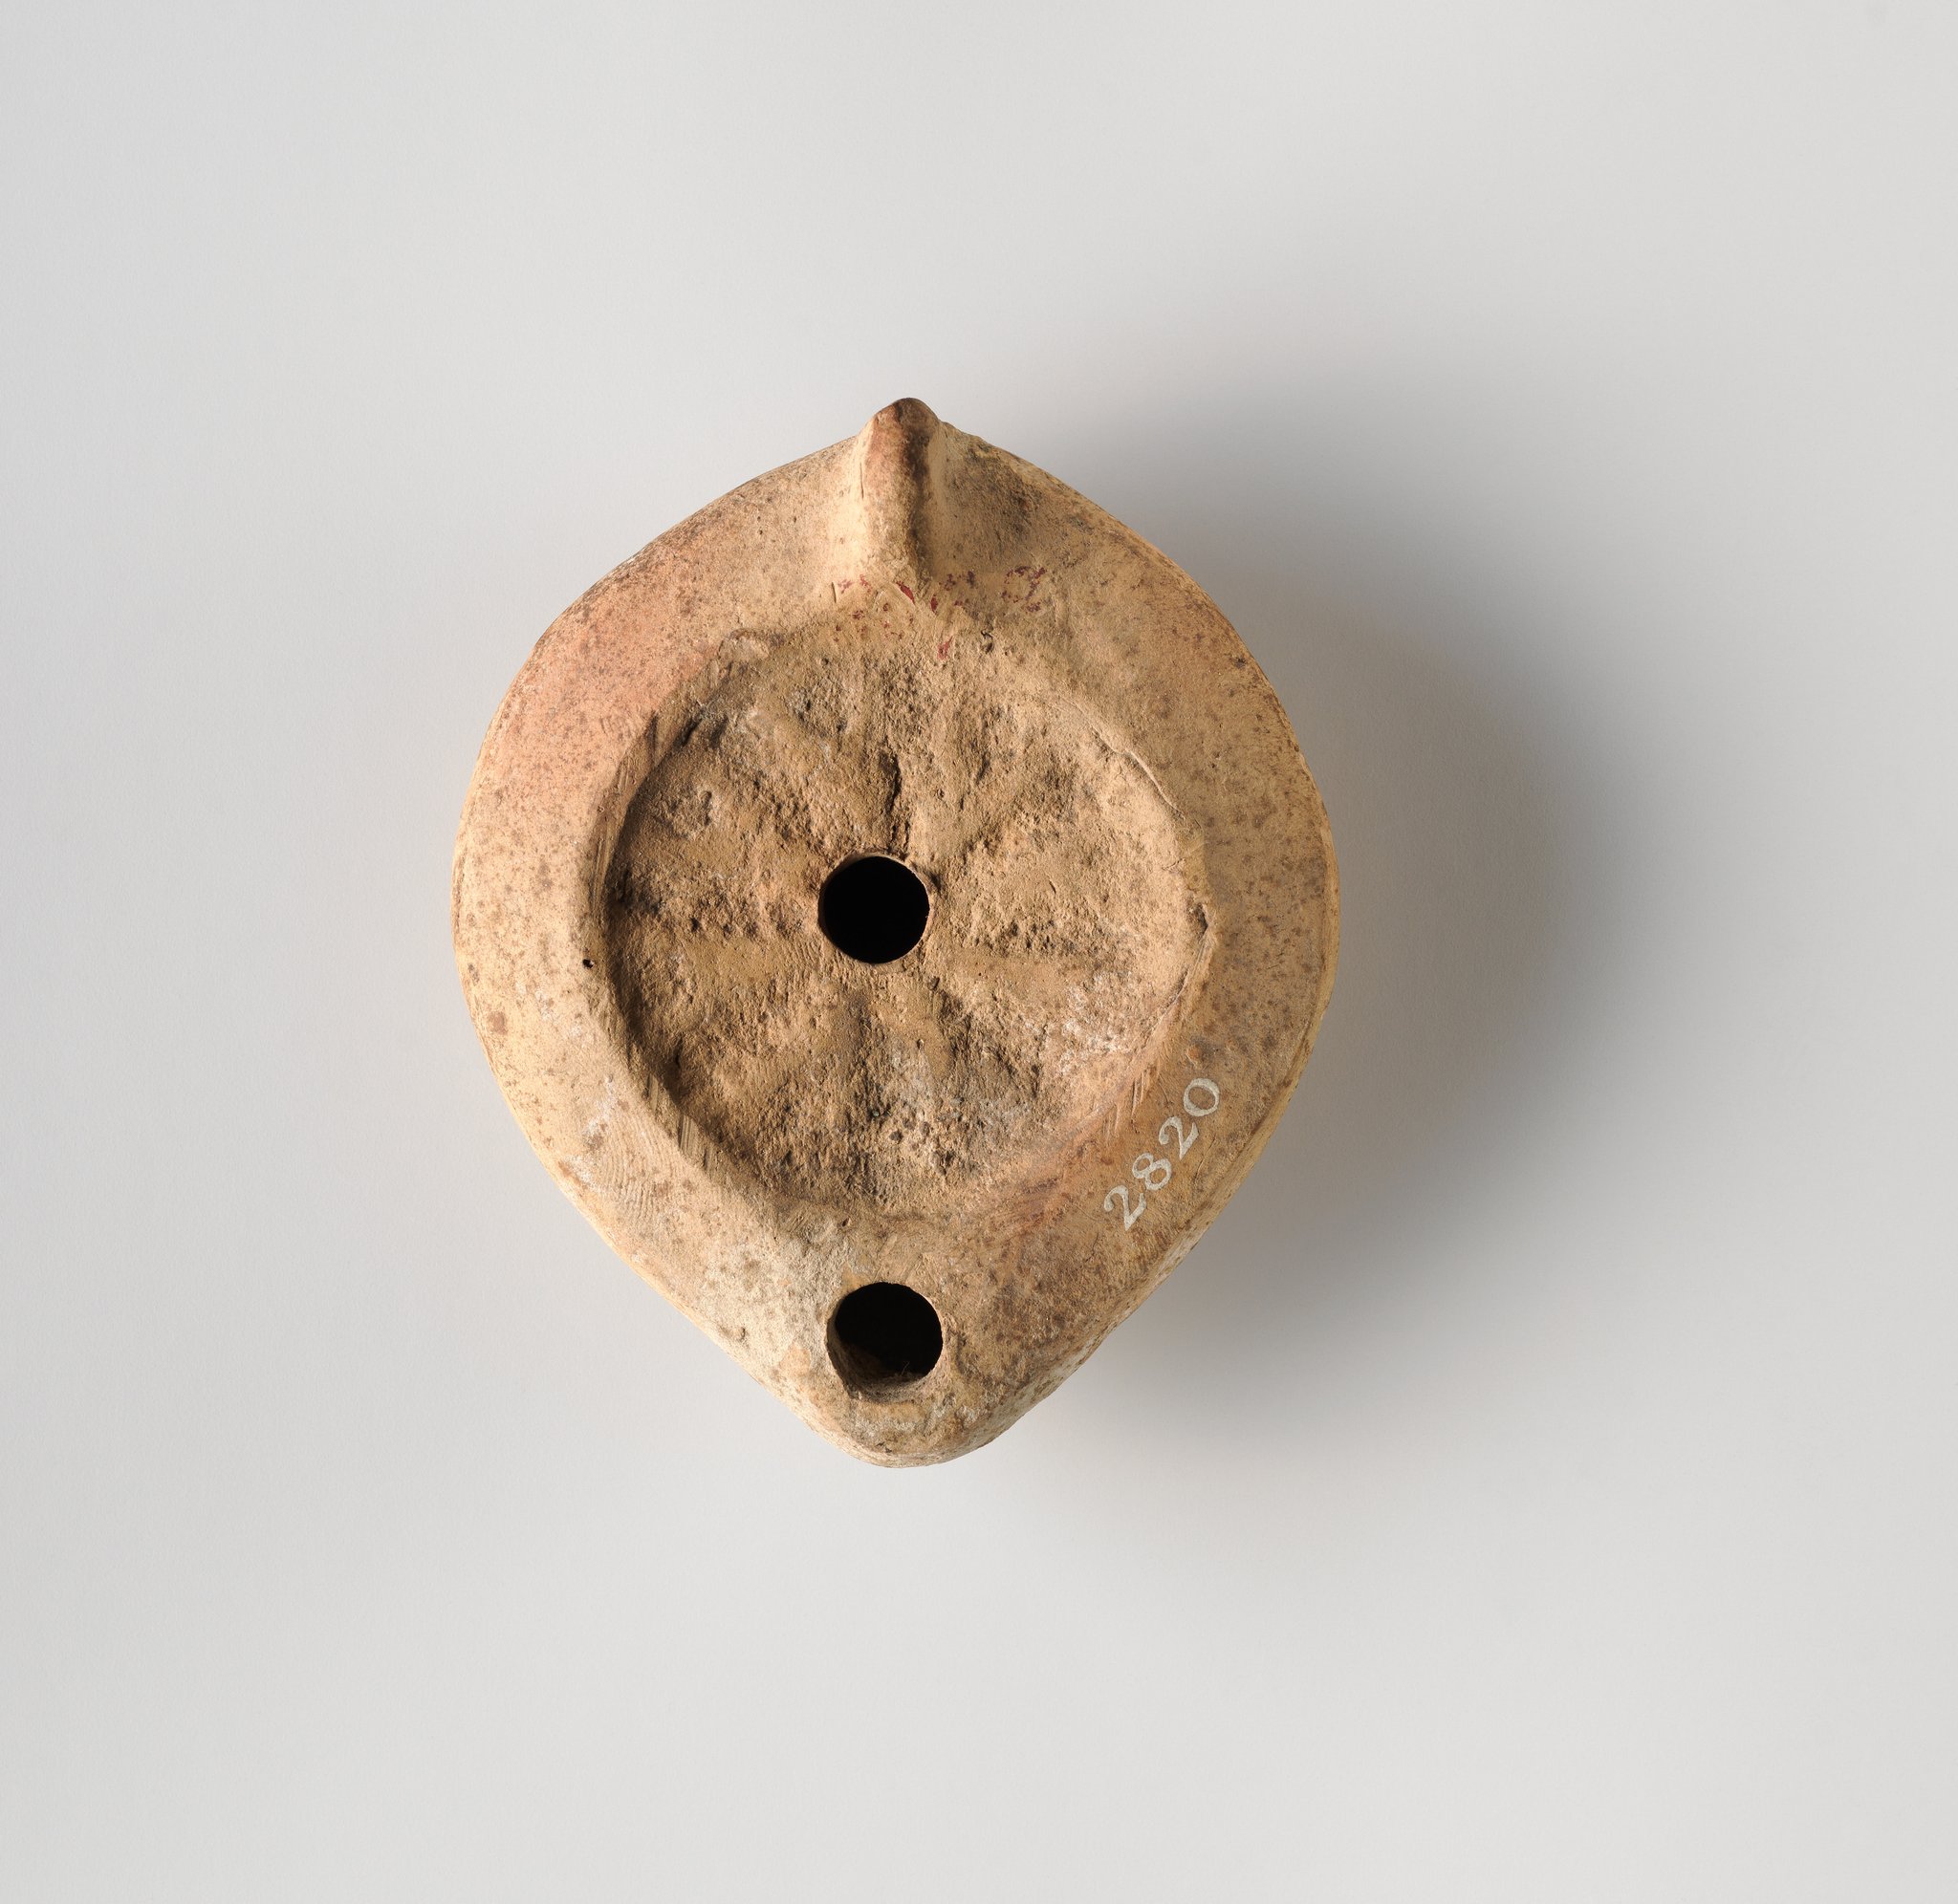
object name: lamp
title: Terracotta oil lamp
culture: roman, cypriot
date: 401-600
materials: terracotta